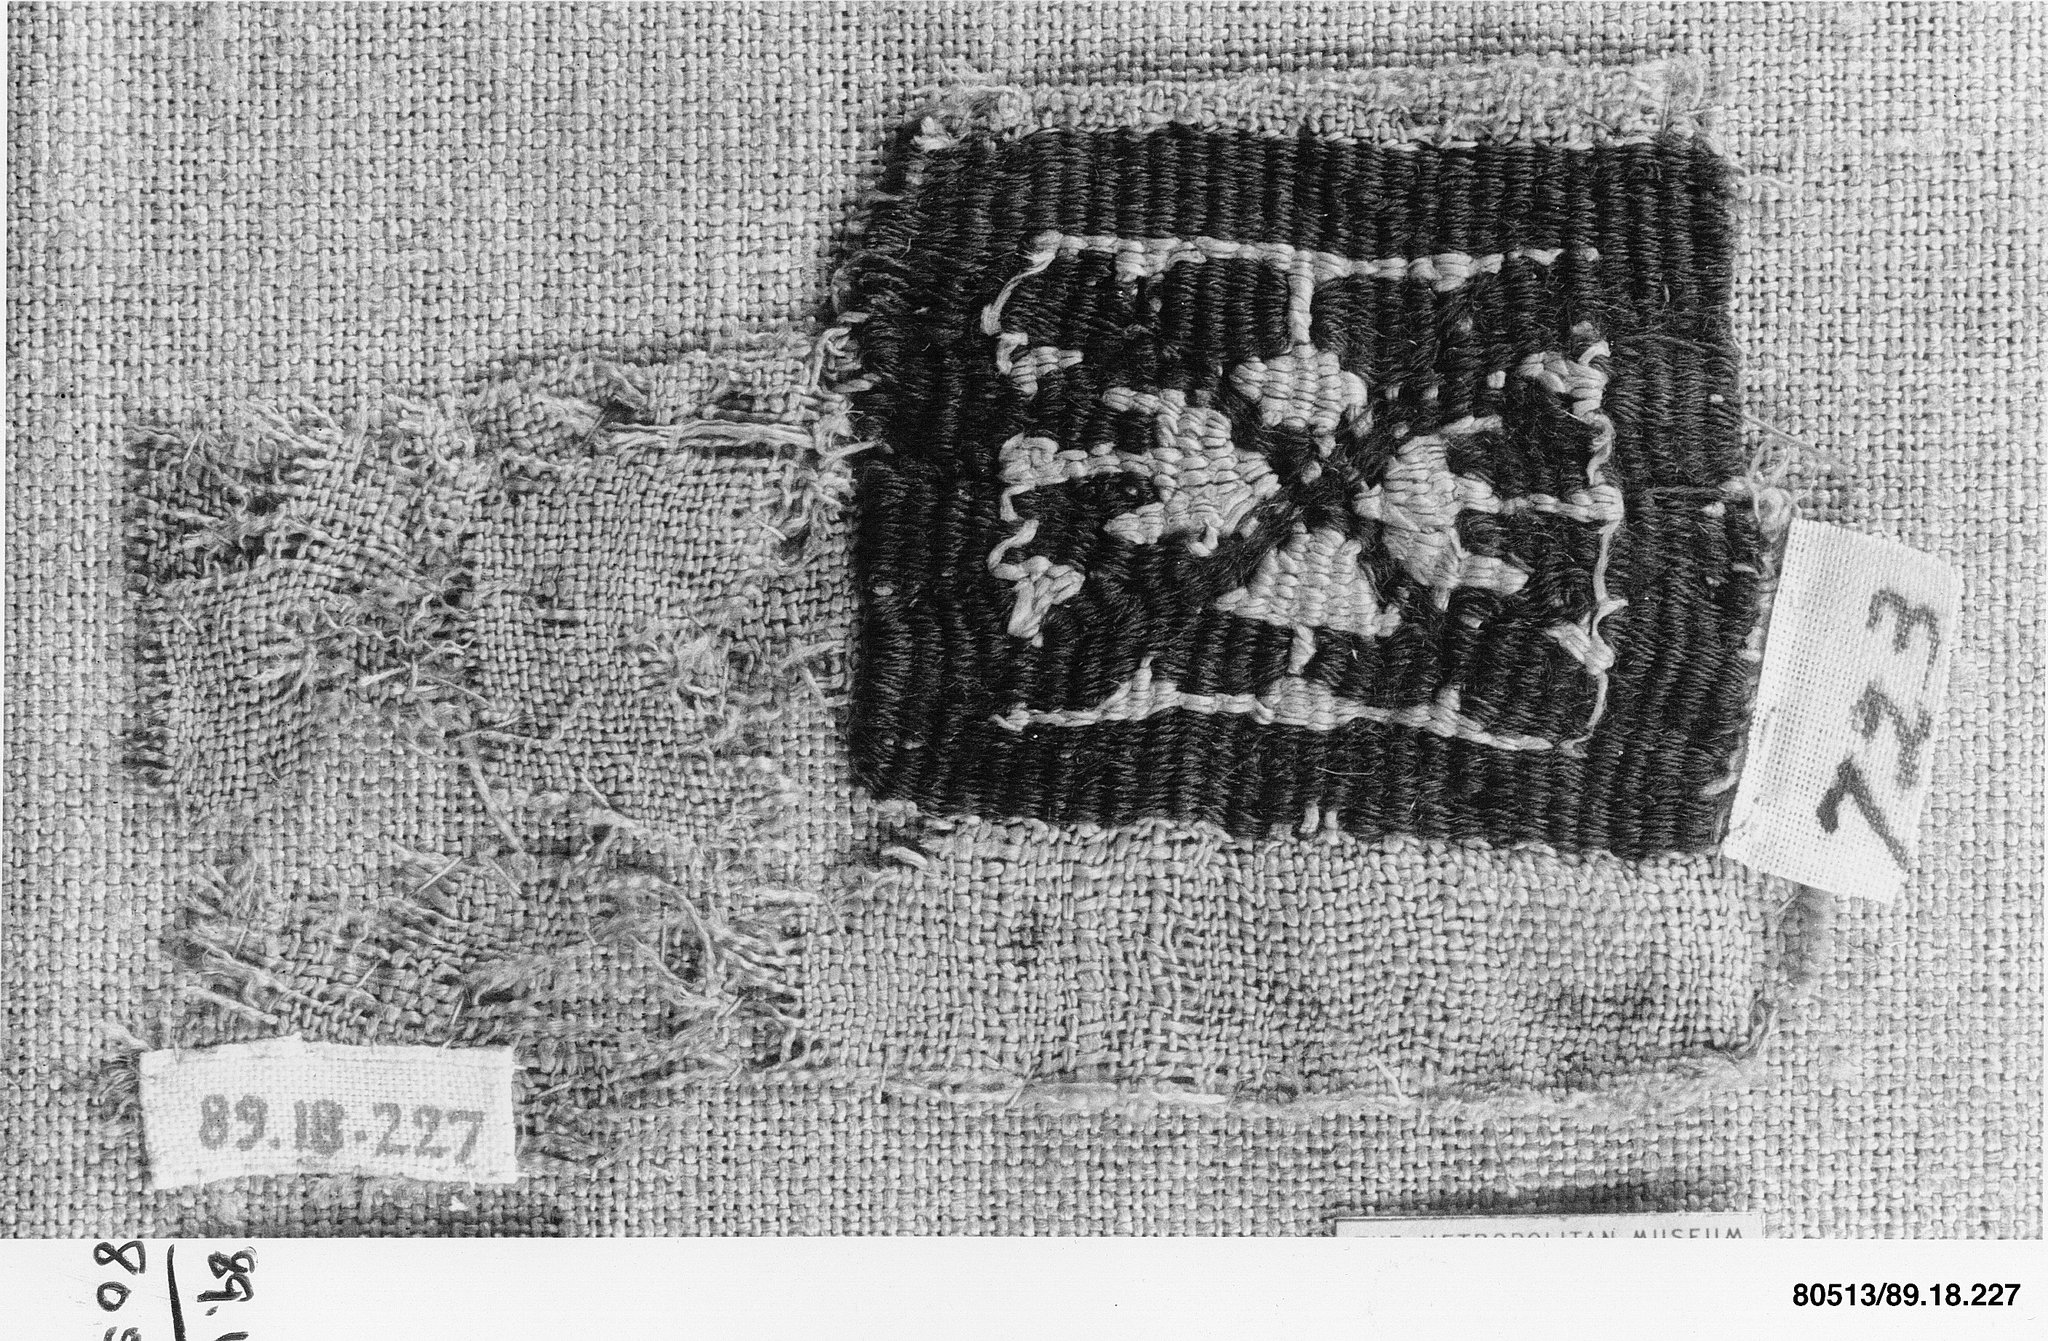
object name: textile fragment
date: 201-400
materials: linen, wool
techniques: weave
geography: egypt